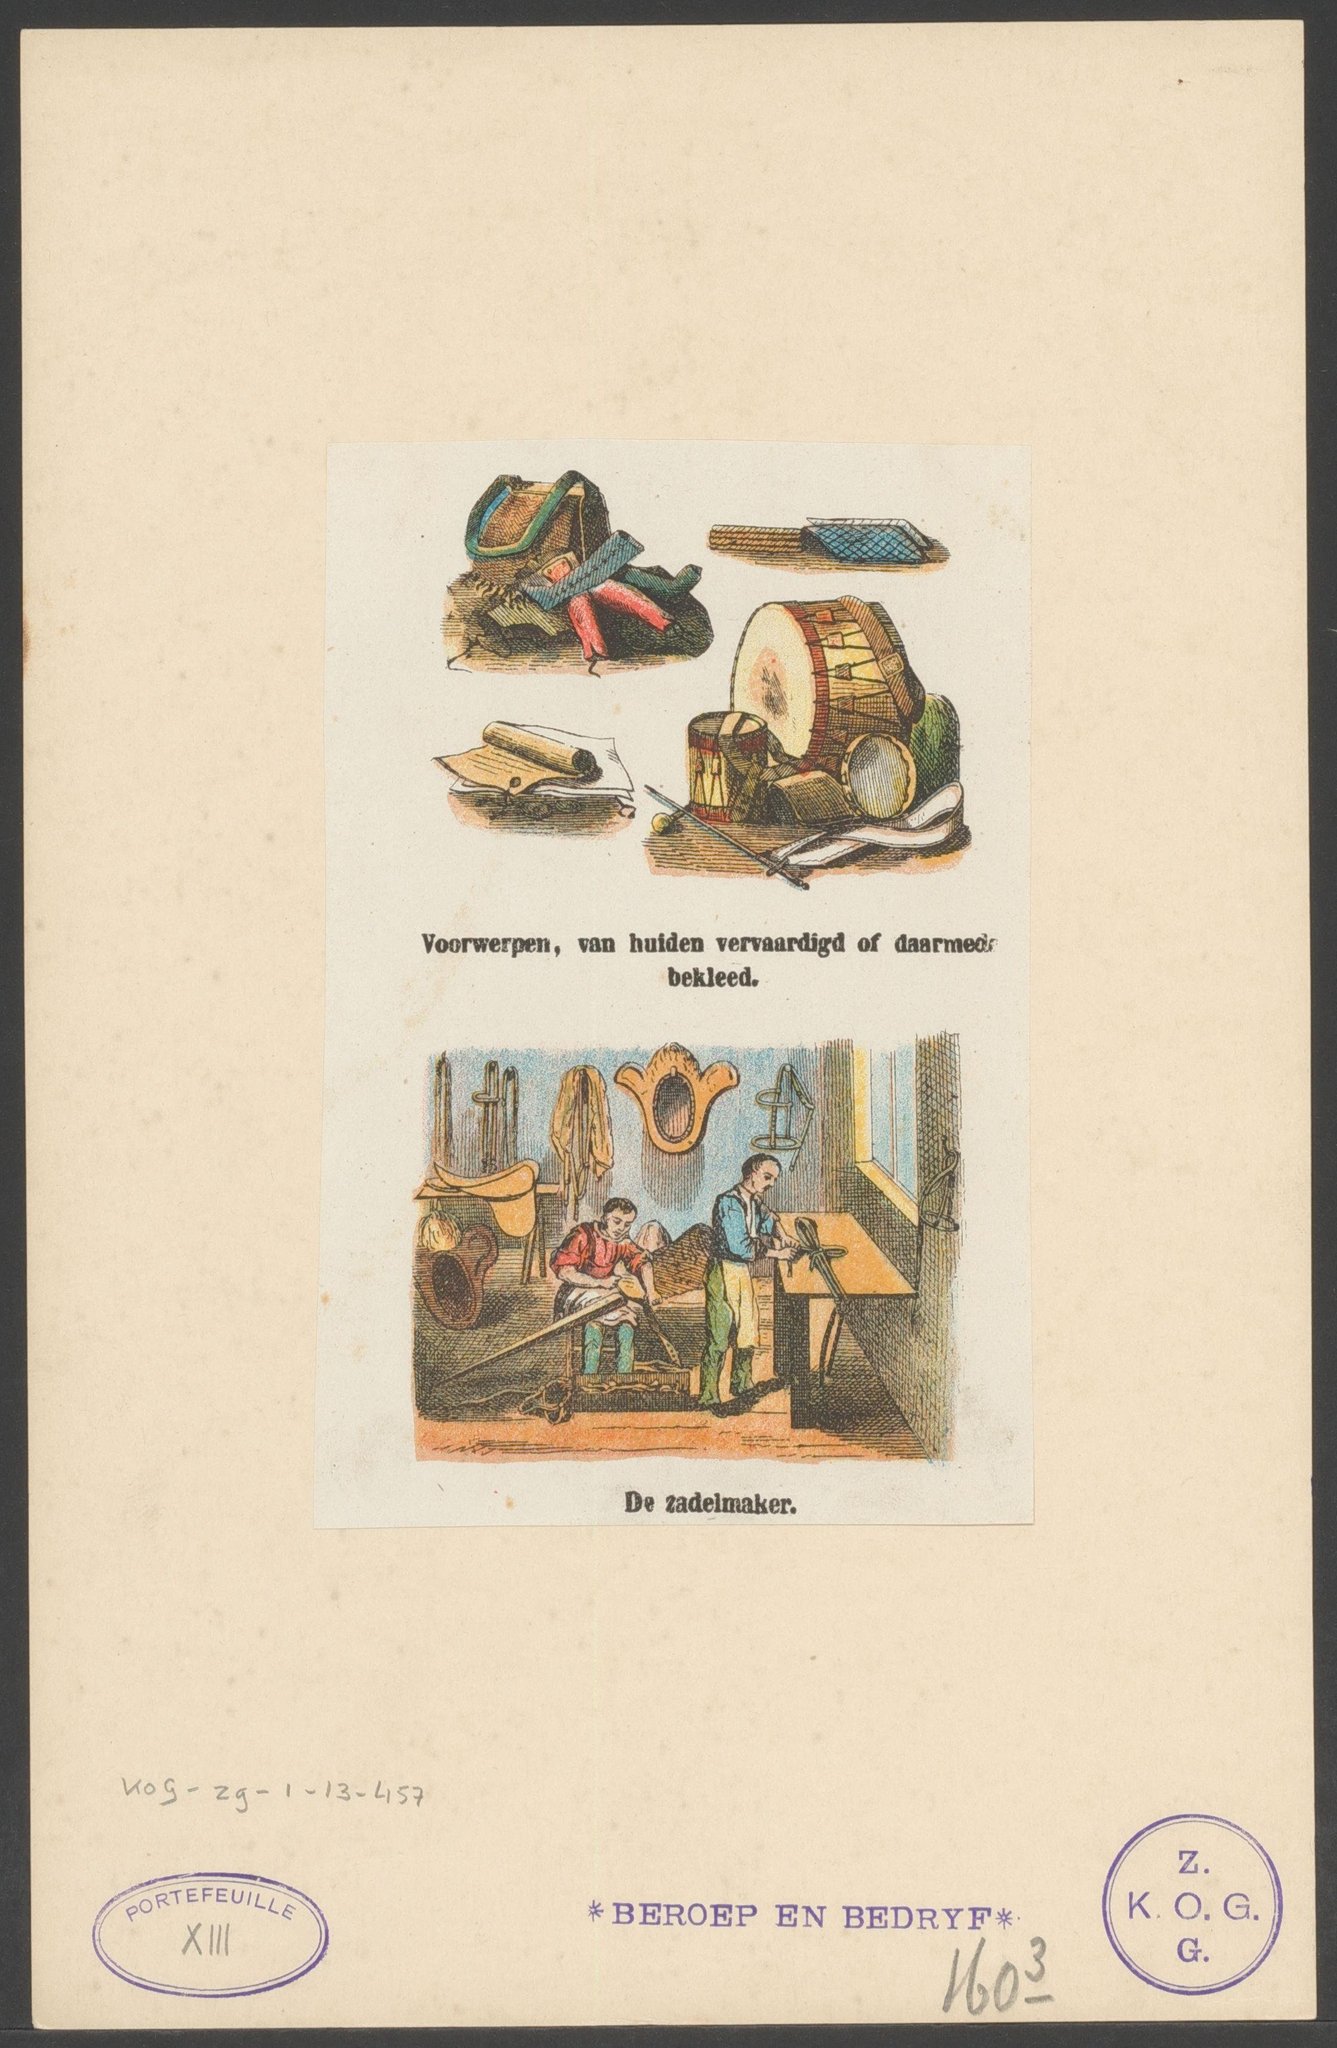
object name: print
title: Voorwerpen van huiden of voorwerpen bekleed met huid en twee zadelmakers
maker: Anonymous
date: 1870-1880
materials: paper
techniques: lithograph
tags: leather industry, manufacture of leather, saddle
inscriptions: stamp, stamp, collector's mark: Lugt 1641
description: Onderwerpsrubrieken binnen de Atlas Zeden en Gewoonten: Handel, Nijverheid en verkeer, Beroep en bedrijf, Mannelijk, Bewerkers van het leder.